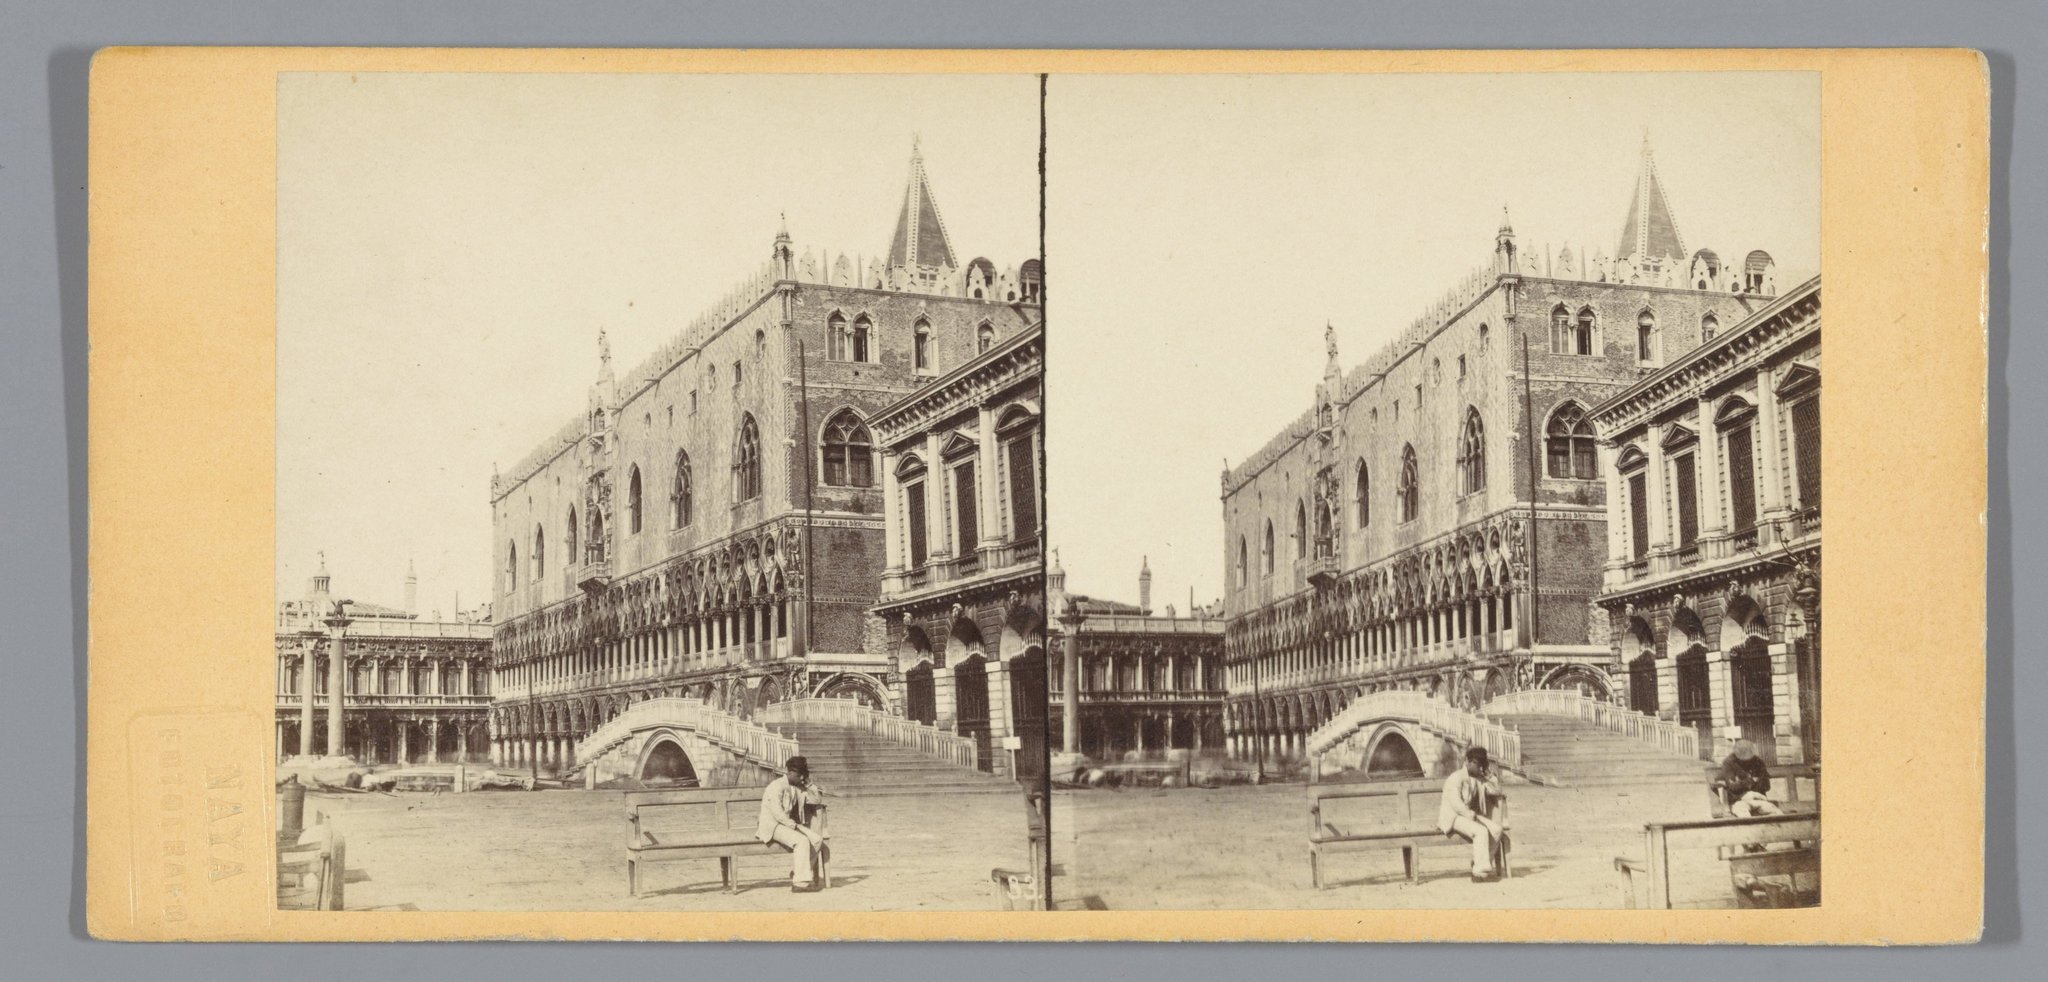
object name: stereograph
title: Gezicht op Ponte della Paglia en het Dogepaleis in Venetië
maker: carlo naya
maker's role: fotograaf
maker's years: 1816-1882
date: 1850-1880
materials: cardboard, photographic support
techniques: albumen print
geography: venice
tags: palace, bridge in city across river, canal, etc.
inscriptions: inscription: ‘Venezia, Prigioni e Palazzo Ducale [...]’, number: ‘33.’